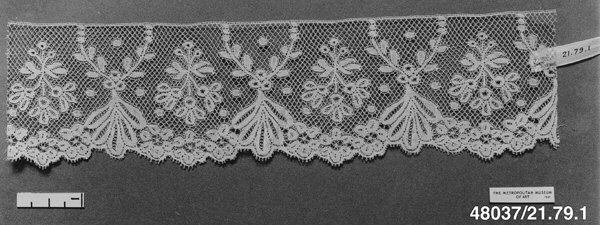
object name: strip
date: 1801-1900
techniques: lace